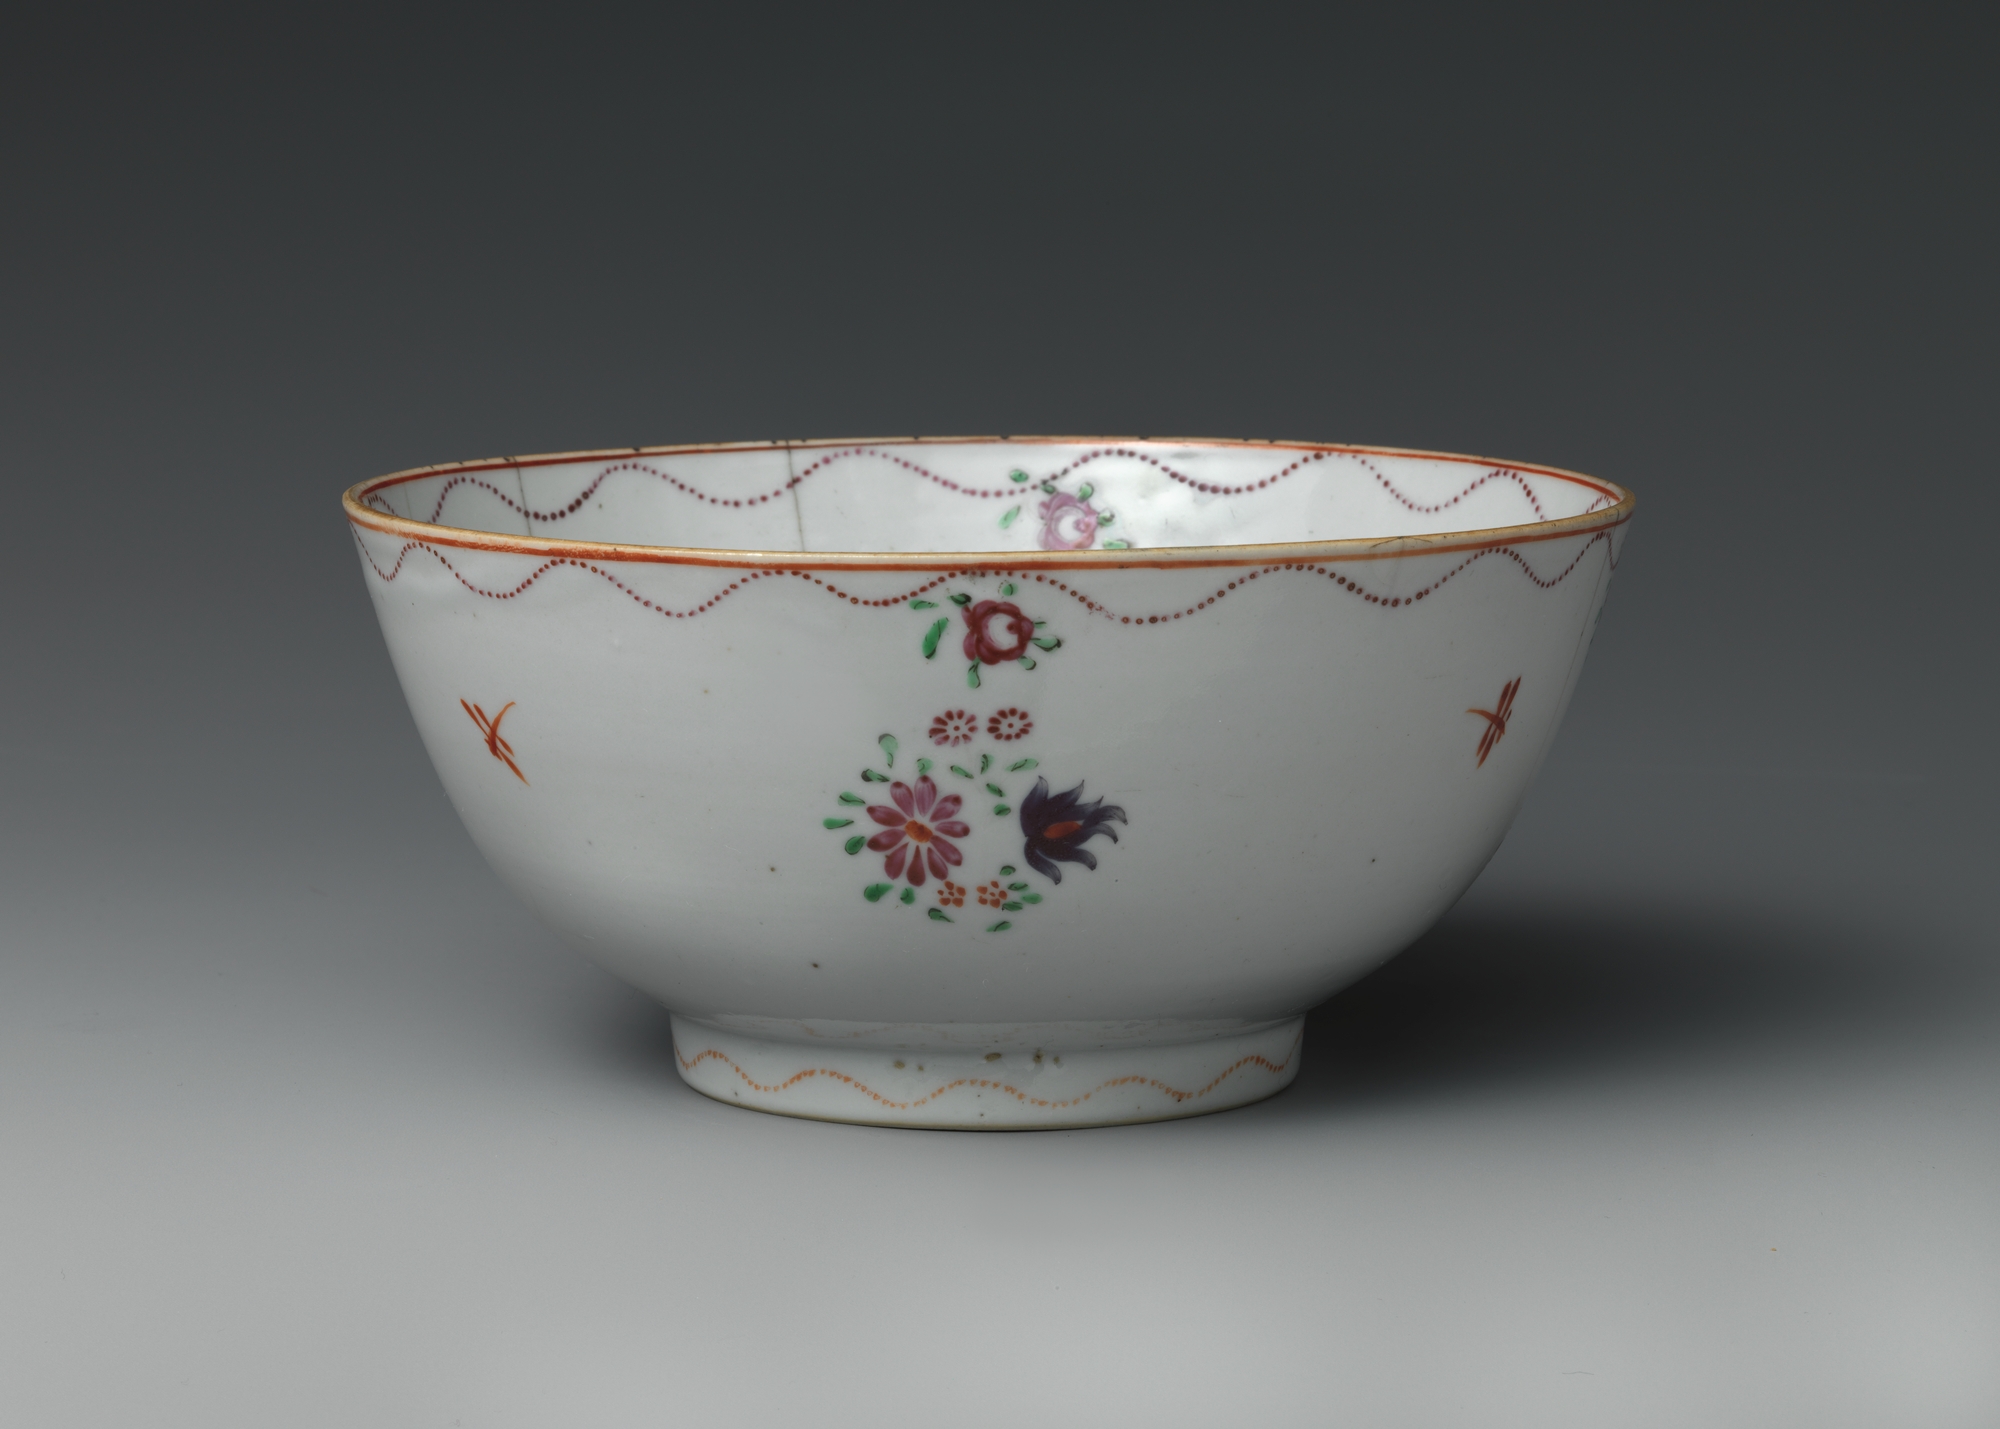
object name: bowl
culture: chinese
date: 1736-1795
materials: porcelain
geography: china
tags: flowers